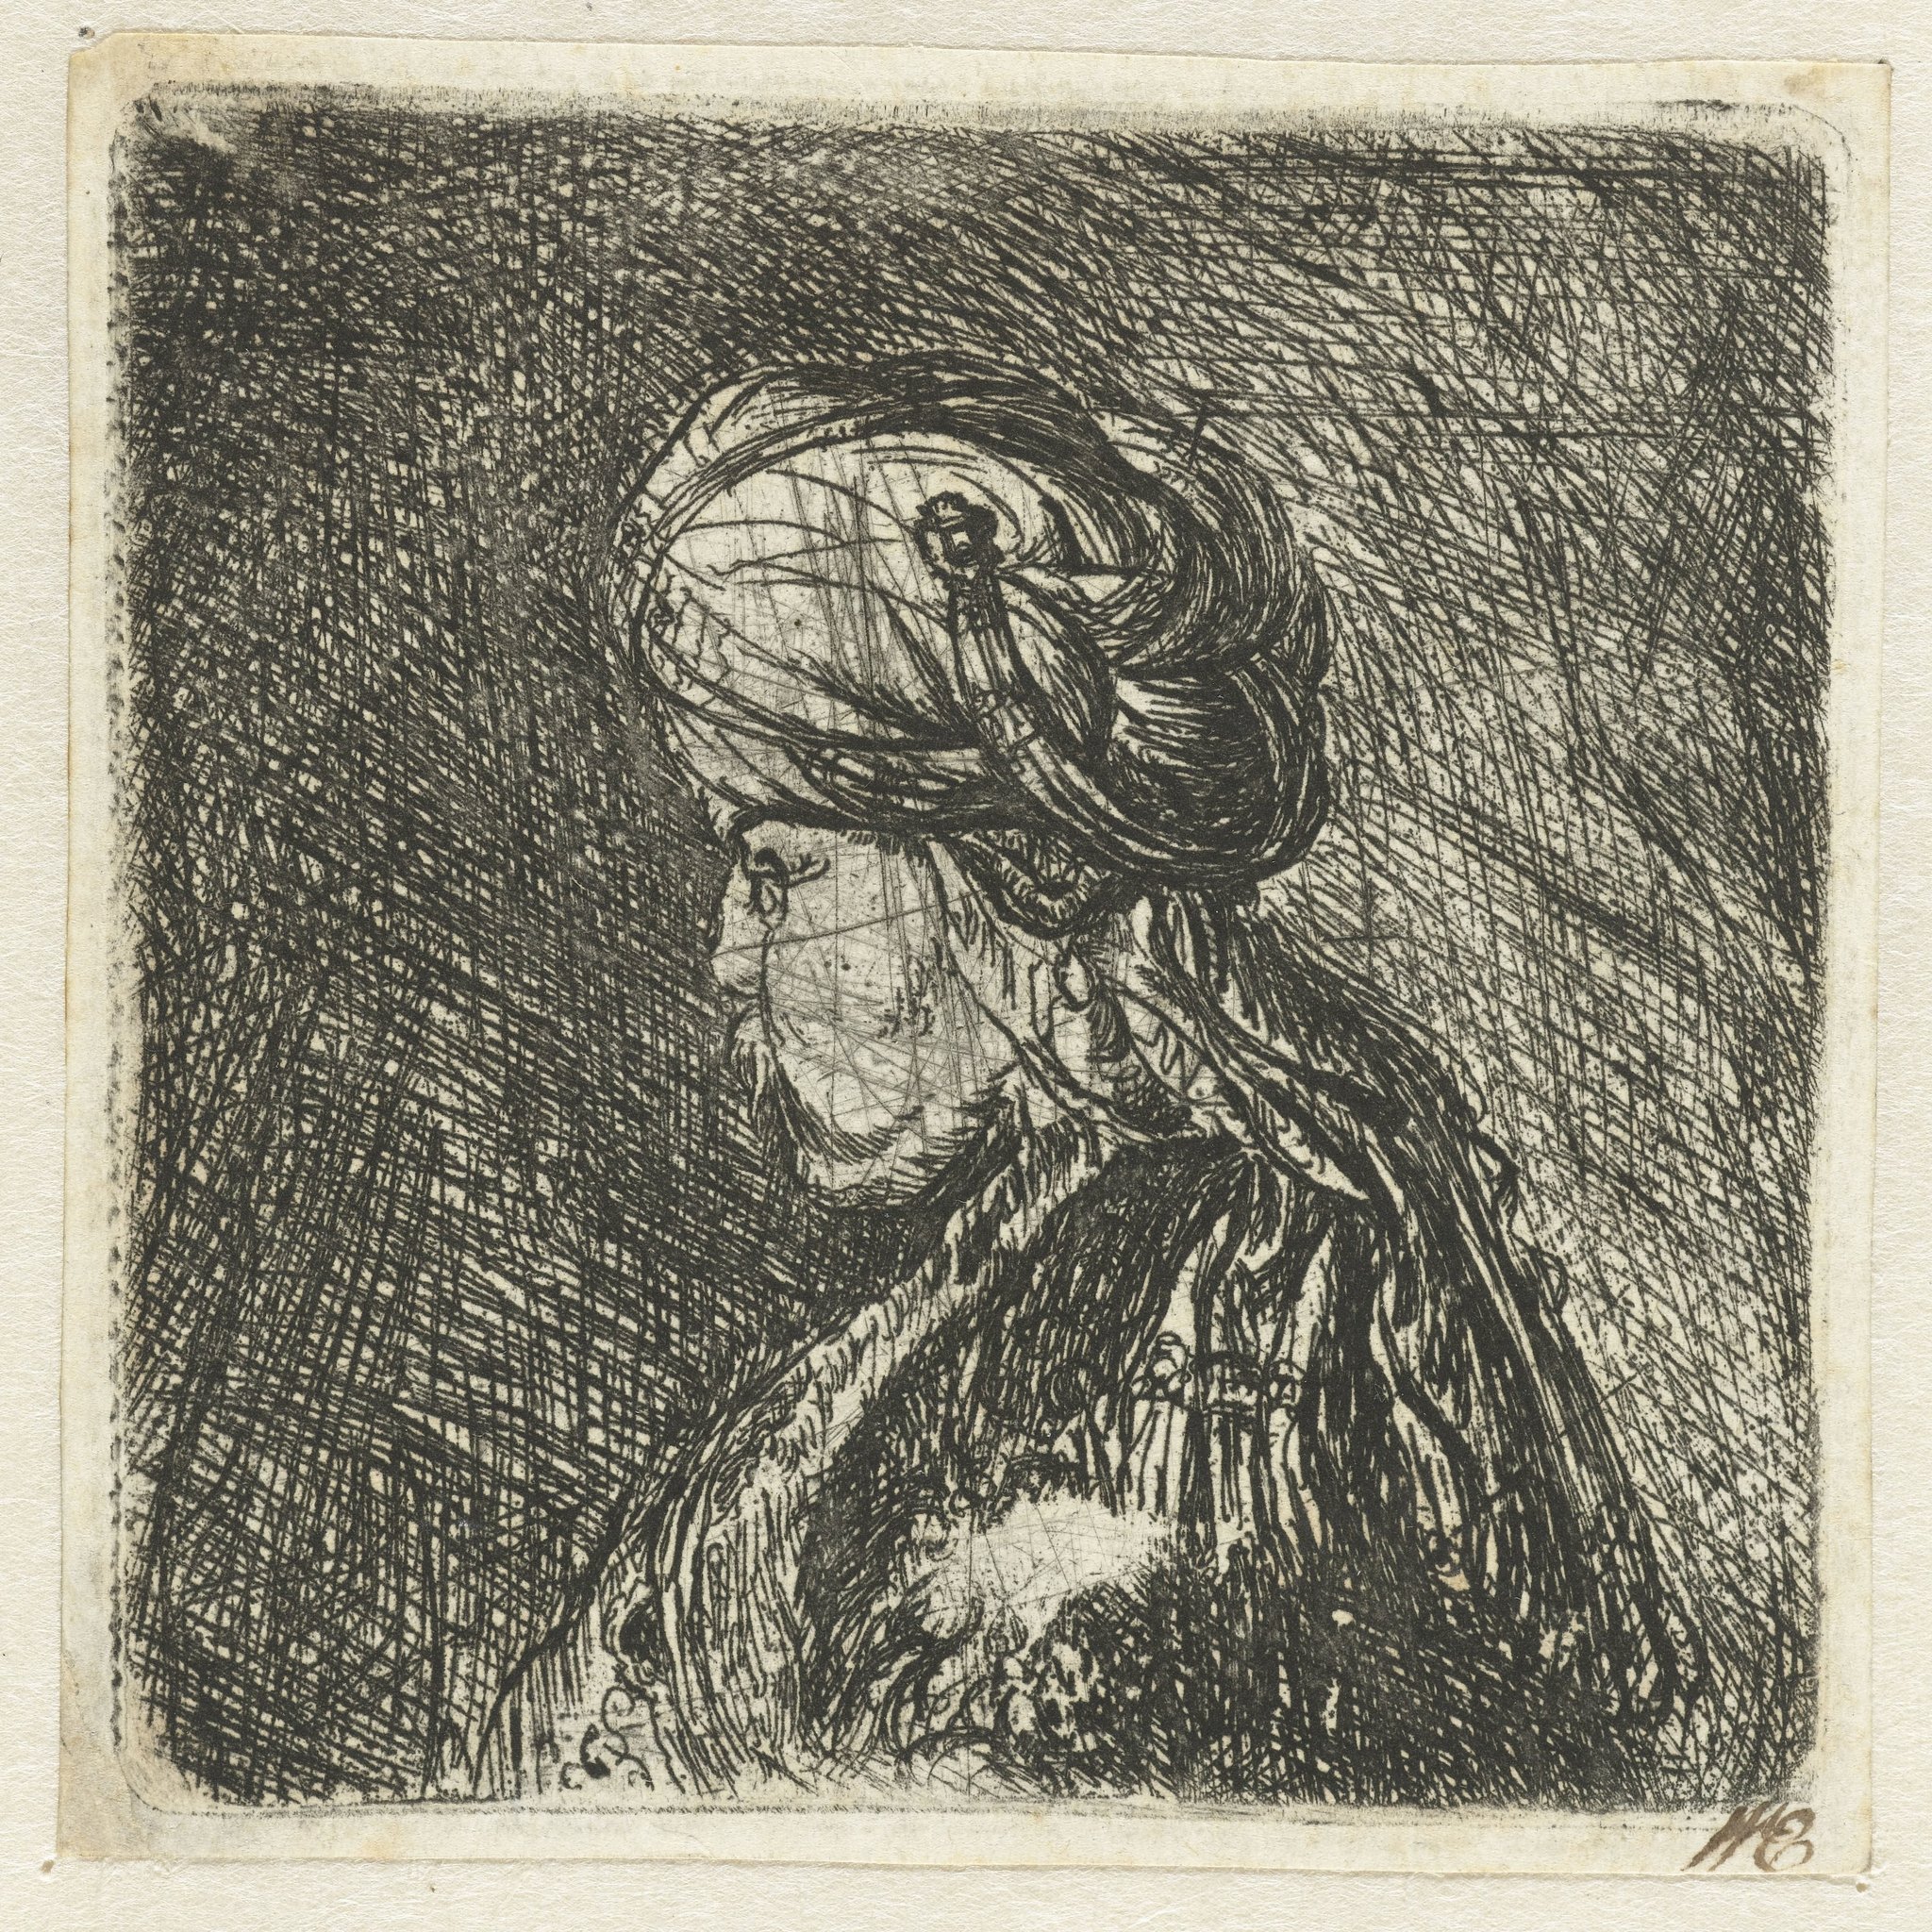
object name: print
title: Borstbeeld van man met tulband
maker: Anonymous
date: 1625-1674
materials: paper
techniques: etching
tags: head-gear: turban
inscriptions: collector's mark: Lugt 2228a, collector's mark: Lugt 2617, collector's mark: Lugt 2617